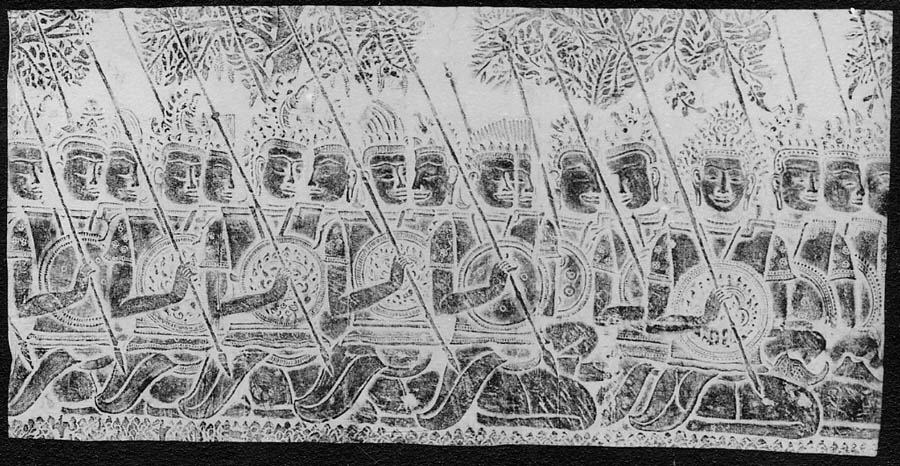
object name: rubbing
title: Rubbing of a Defiling Army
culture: cambodian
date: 1901-2000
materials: ink, paper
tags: army